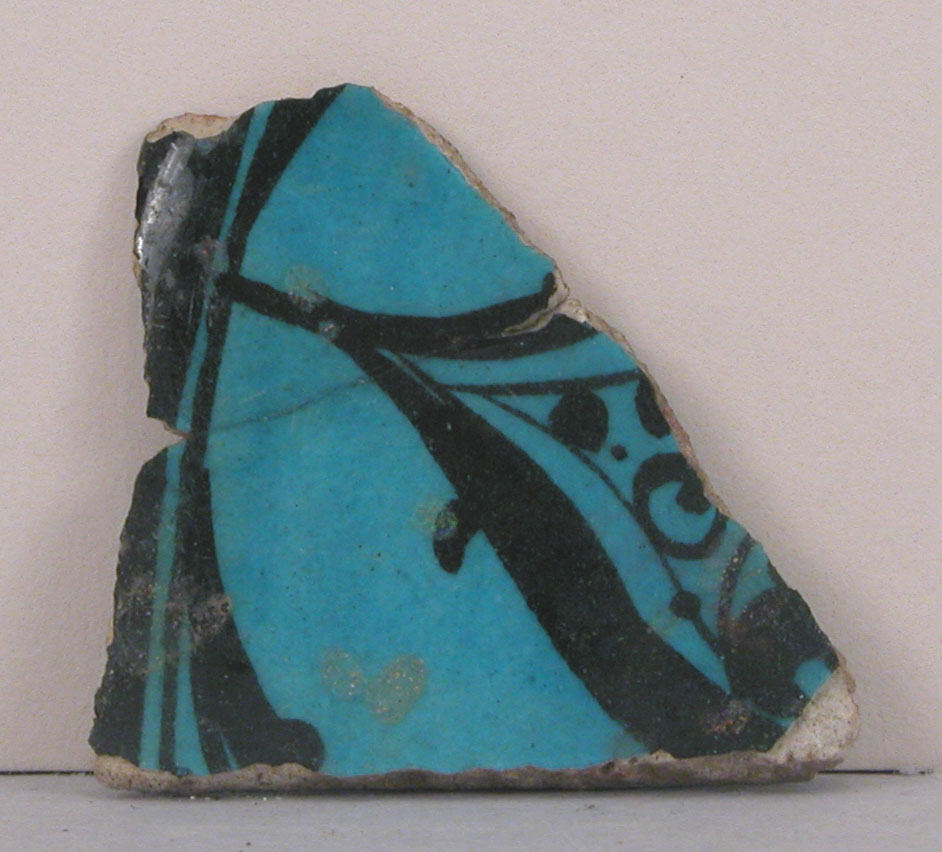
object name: fragment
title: Fragment of a Bowl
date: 1201-1300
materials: stonepaste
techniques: painting, underglaze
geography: syria